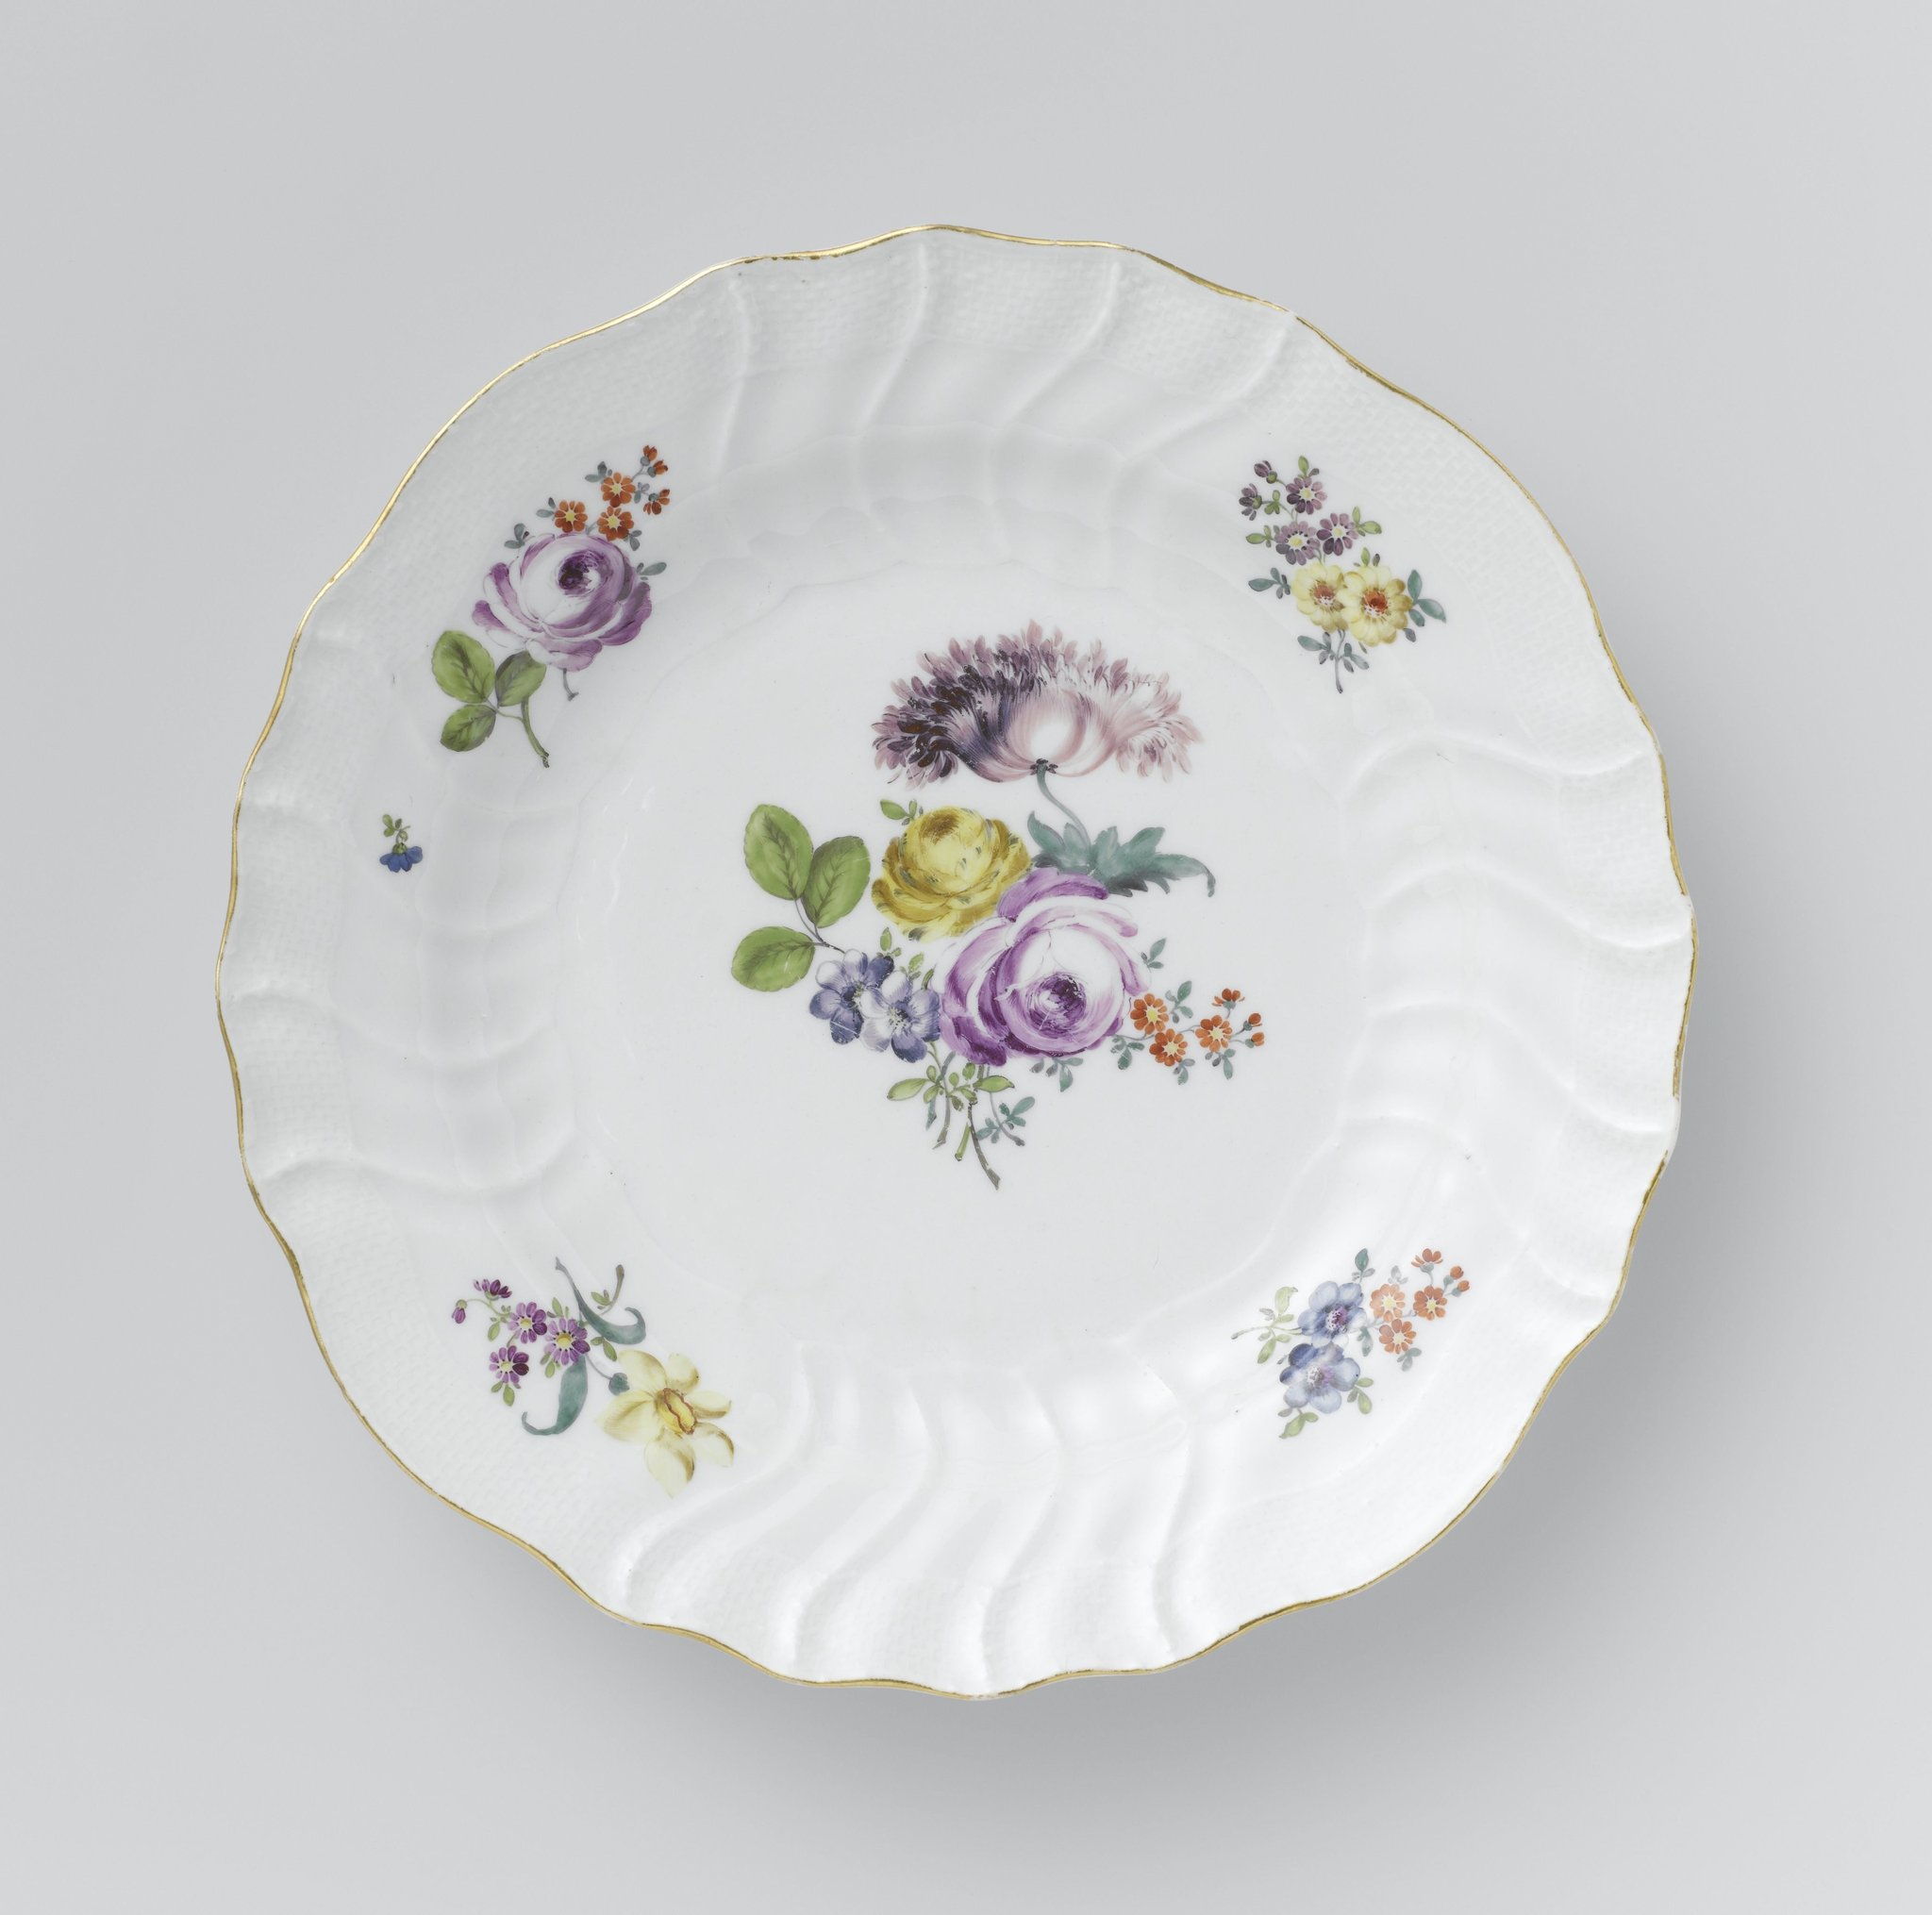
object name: plate dish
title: Bord, veelkleurig beschilderd met Deutsche Blumen, insekten en vruchten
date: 1750-1760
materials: porcelain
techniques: painted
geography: meissen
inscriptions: factory mark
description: Rond bord van beschilderd porselein. De rand is versierd met het Neuozier-patroon. De beschildering bestaat uit Deutsche Blumen, insekten en vruchten. Het bord is gemerkt en hoort bij een servies (BK-17474-1 t/m BK-17474-253).